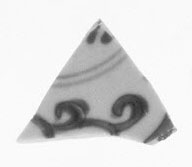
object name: shard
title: Shard (Study Collection)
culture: chinese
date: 1368-1911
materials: porcelain